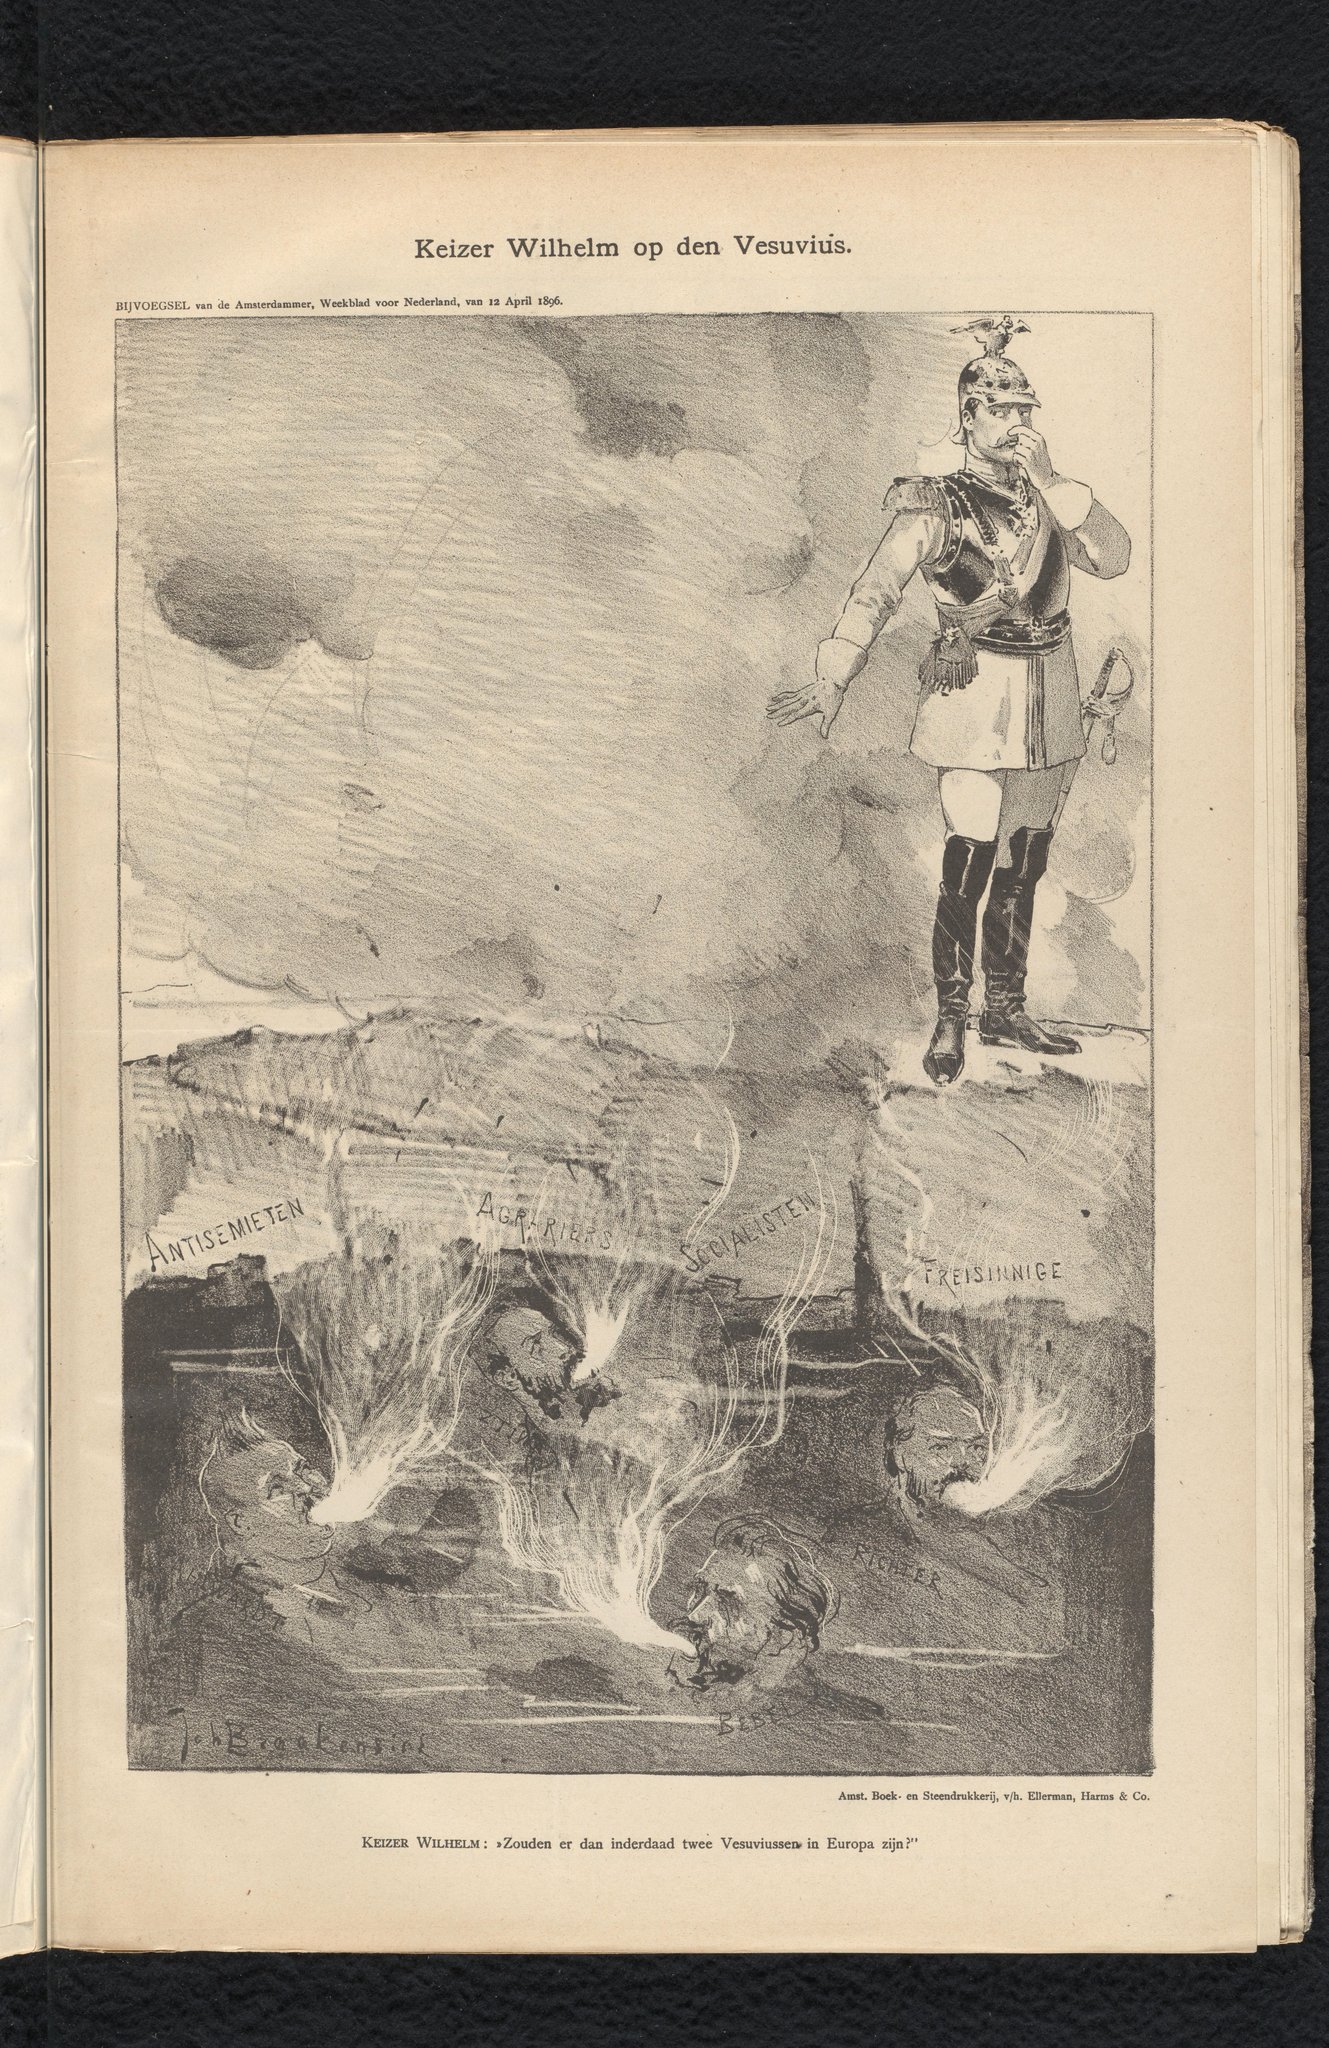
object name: cartoon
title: Keizer Wilhelm op de Vesuvius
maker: johan braakensiek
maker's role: draughtsman, print maker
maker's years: 1858-1940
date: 1896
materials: paper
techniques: lithograph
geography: amsterdam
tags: wilhelm ii (keizer van duitsland), disagreeable, repellent smell, holding one's nose, mount vesuvius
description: Keizer Wilhelm II knijpt zijn neus dicht tegen de stank van de oprijzende dampen van onder anderen antisemieten en socialisten.